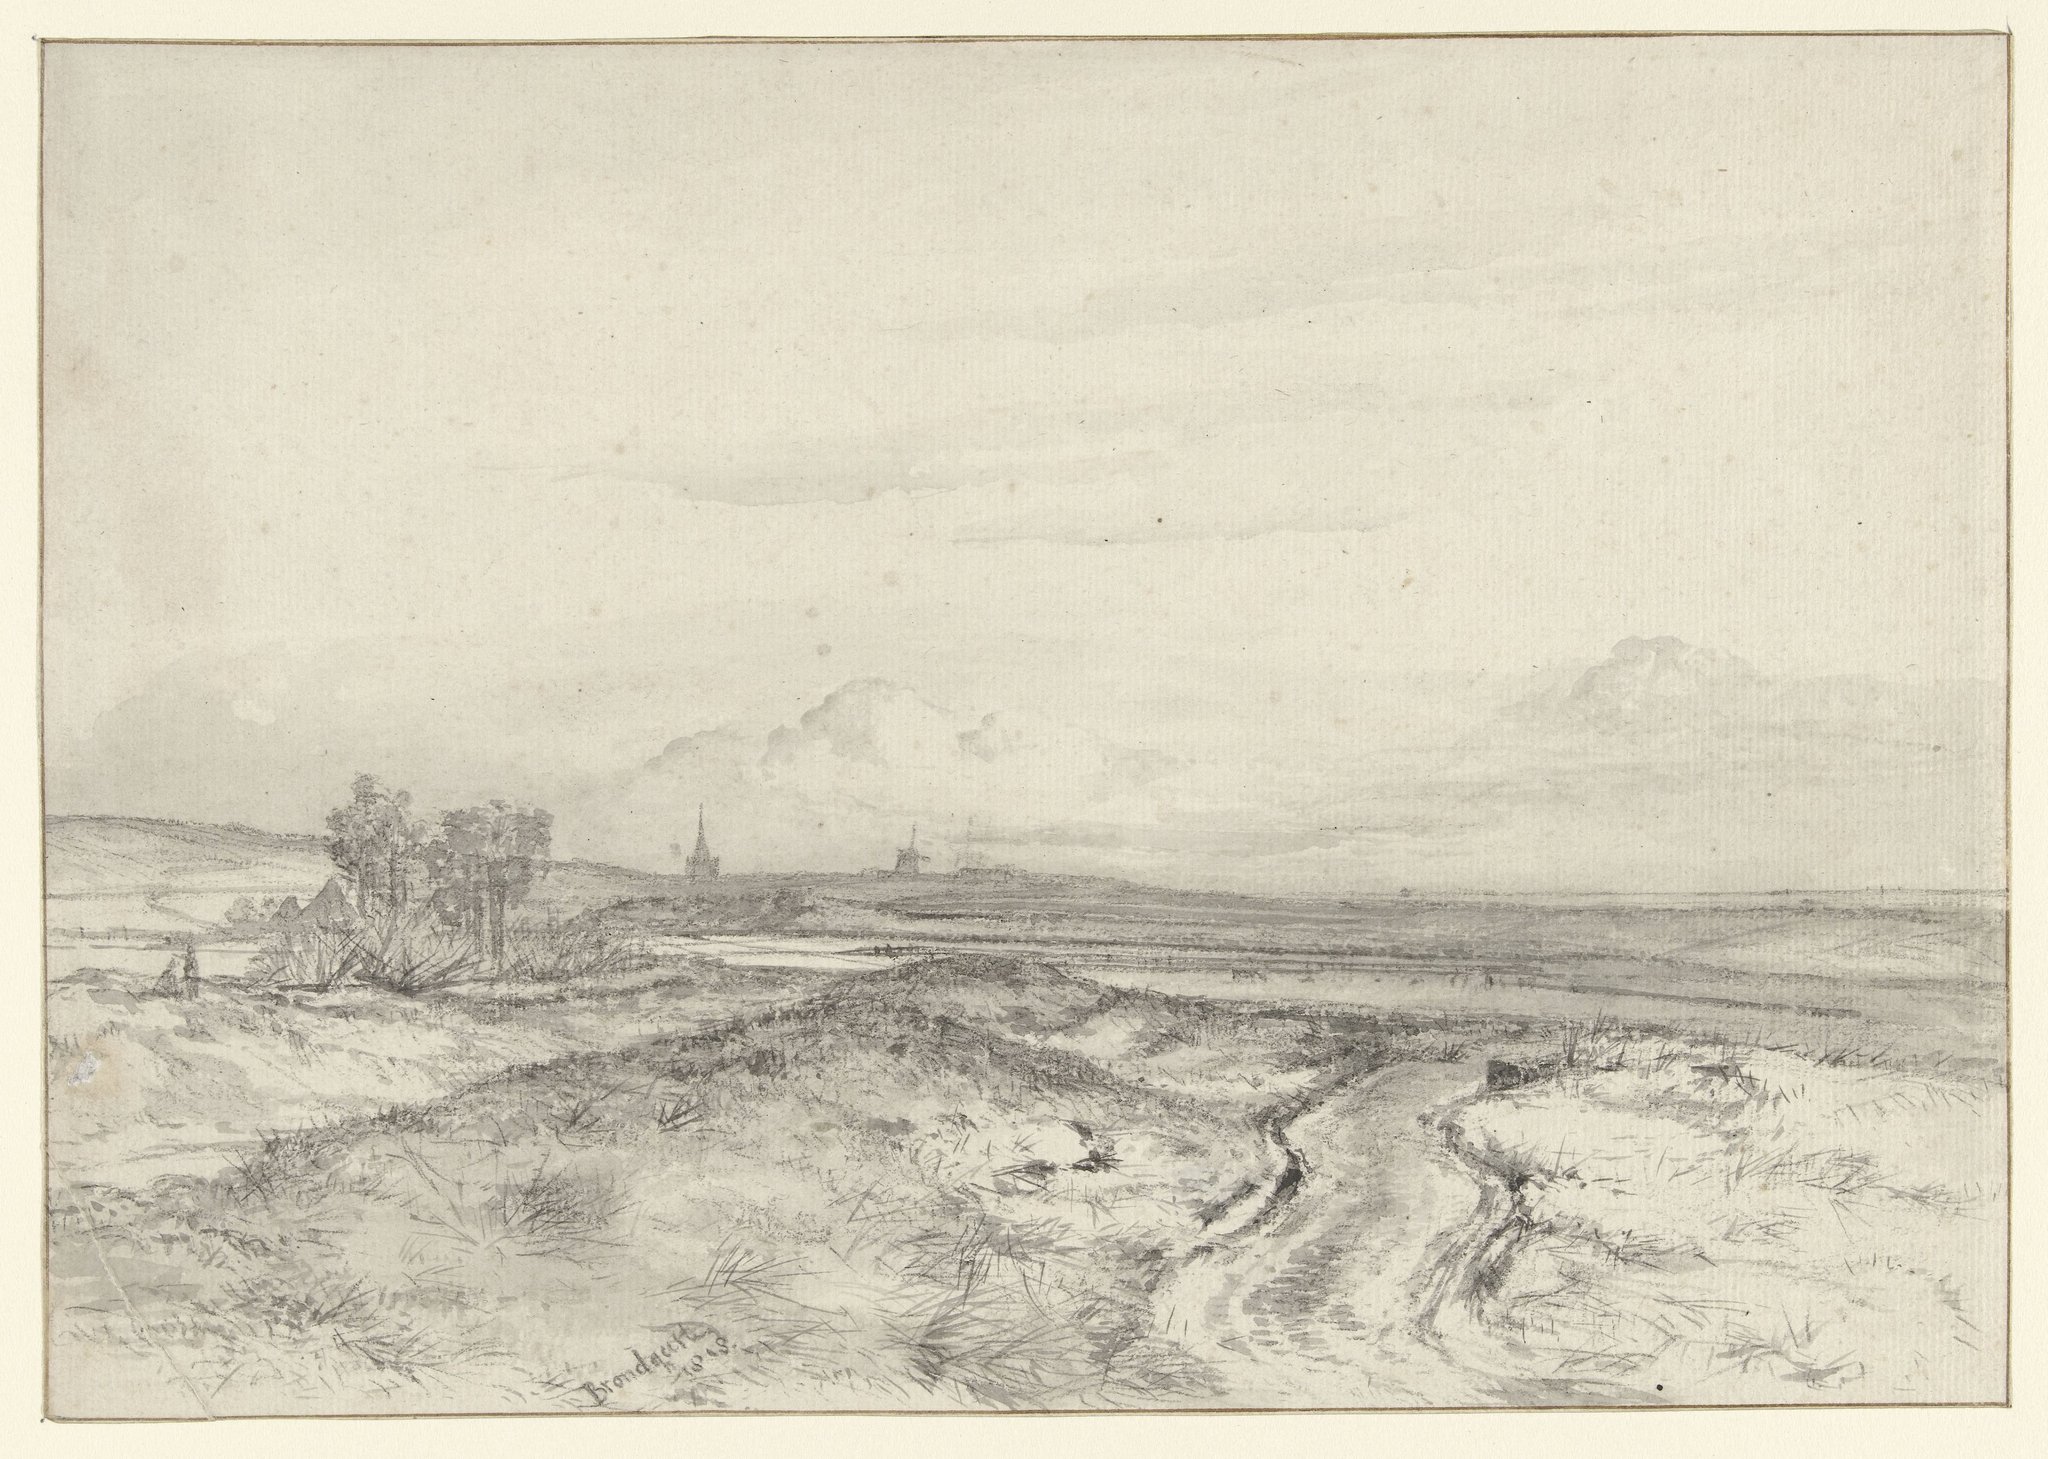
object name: drawing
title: Panorama van licht glooiend landschap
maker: albertus brondgeest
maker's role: draughtsman, print maker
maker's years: 1786-1849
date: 1818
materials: chalk, paper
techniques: brush